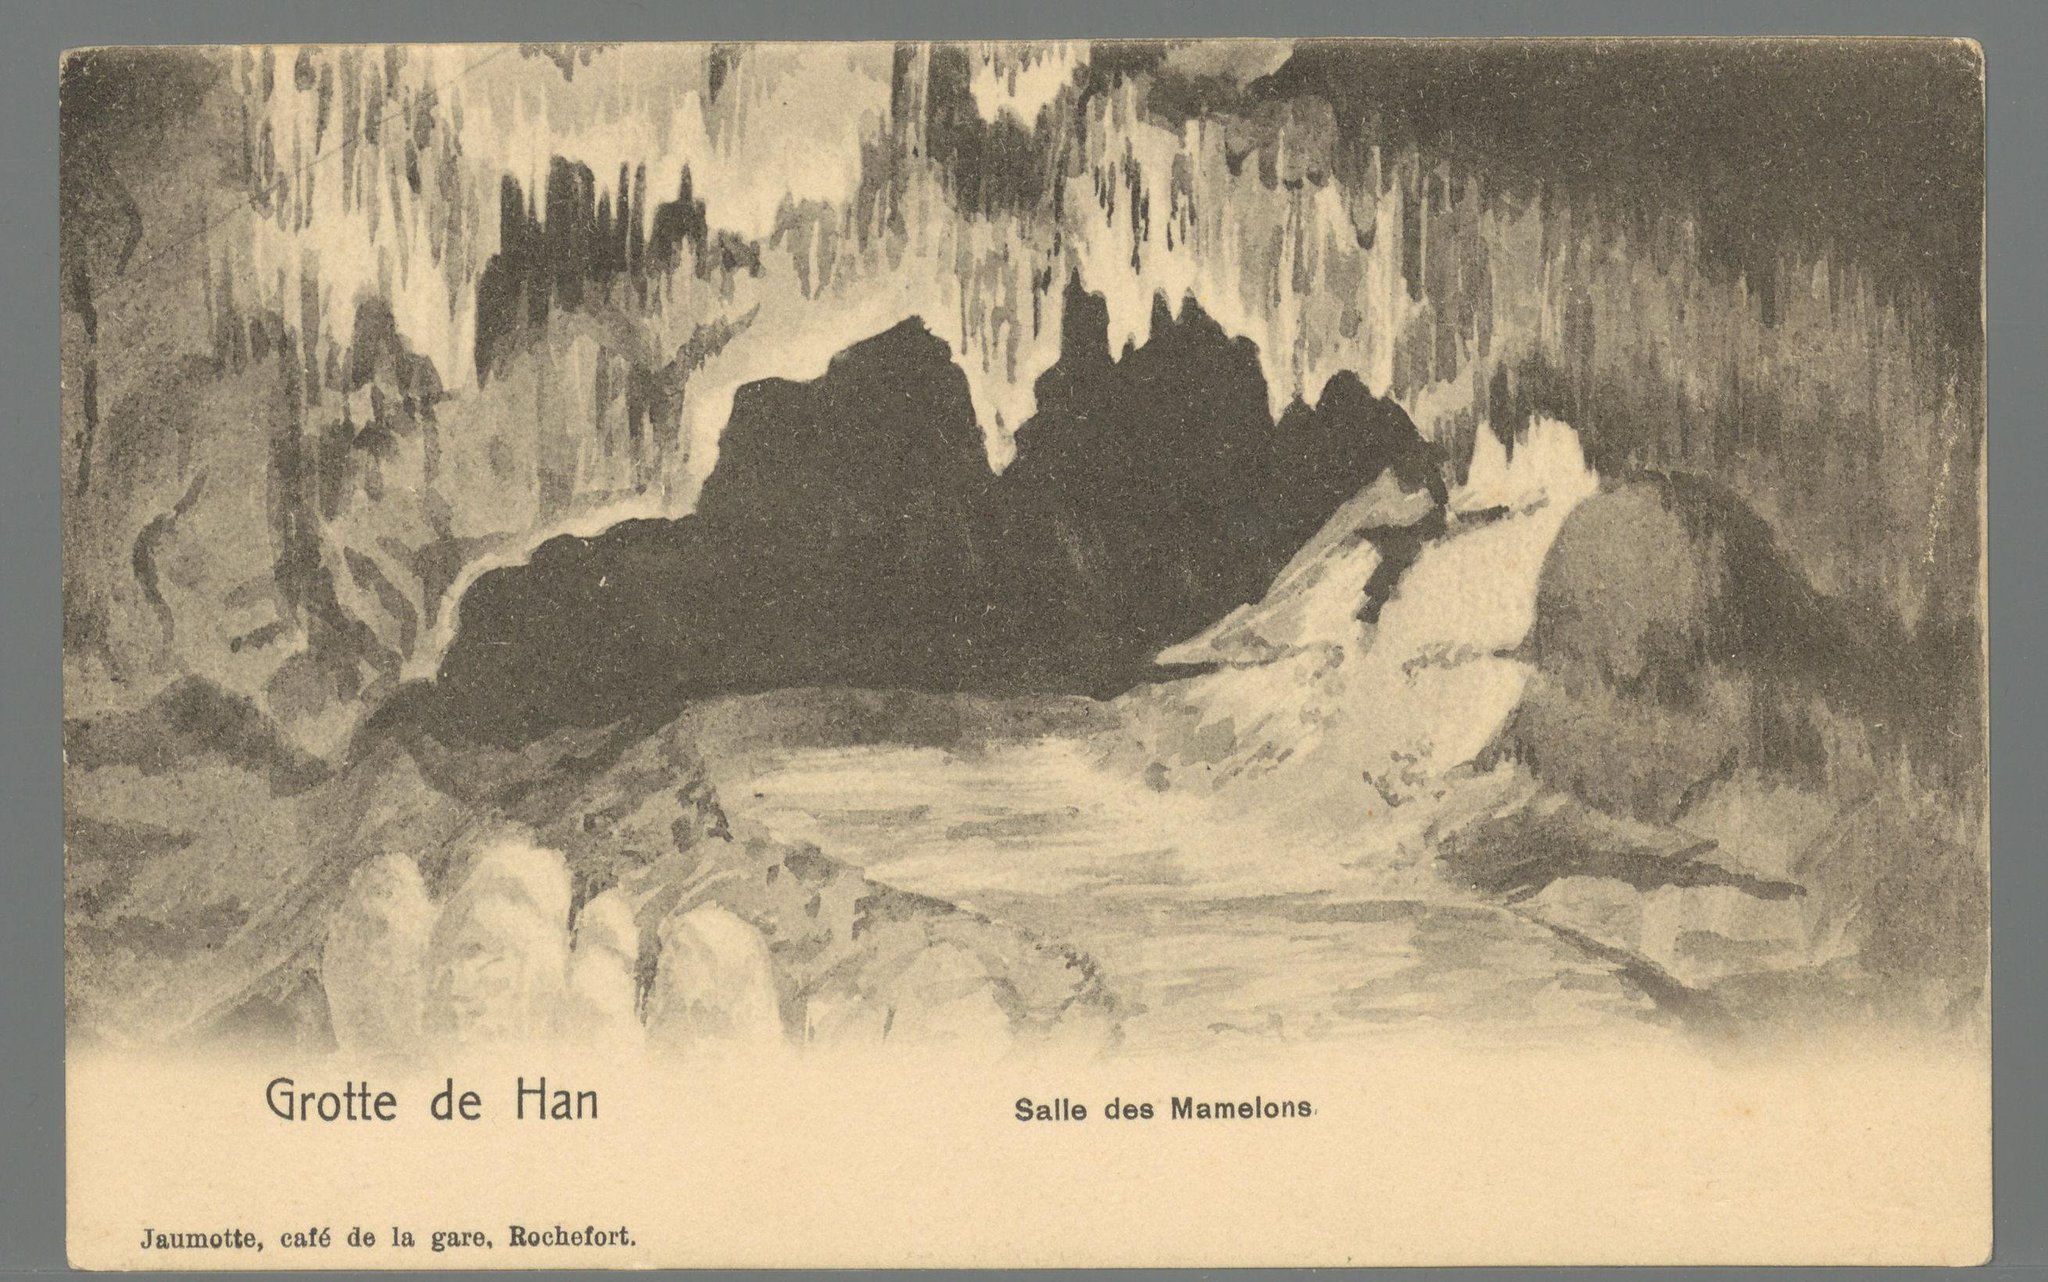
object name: photomechanical print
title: Grotte de Han. Salle des Mamelons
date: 1897-1906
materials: cardboard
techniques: photograph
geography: rochefort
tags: stalactitic cave